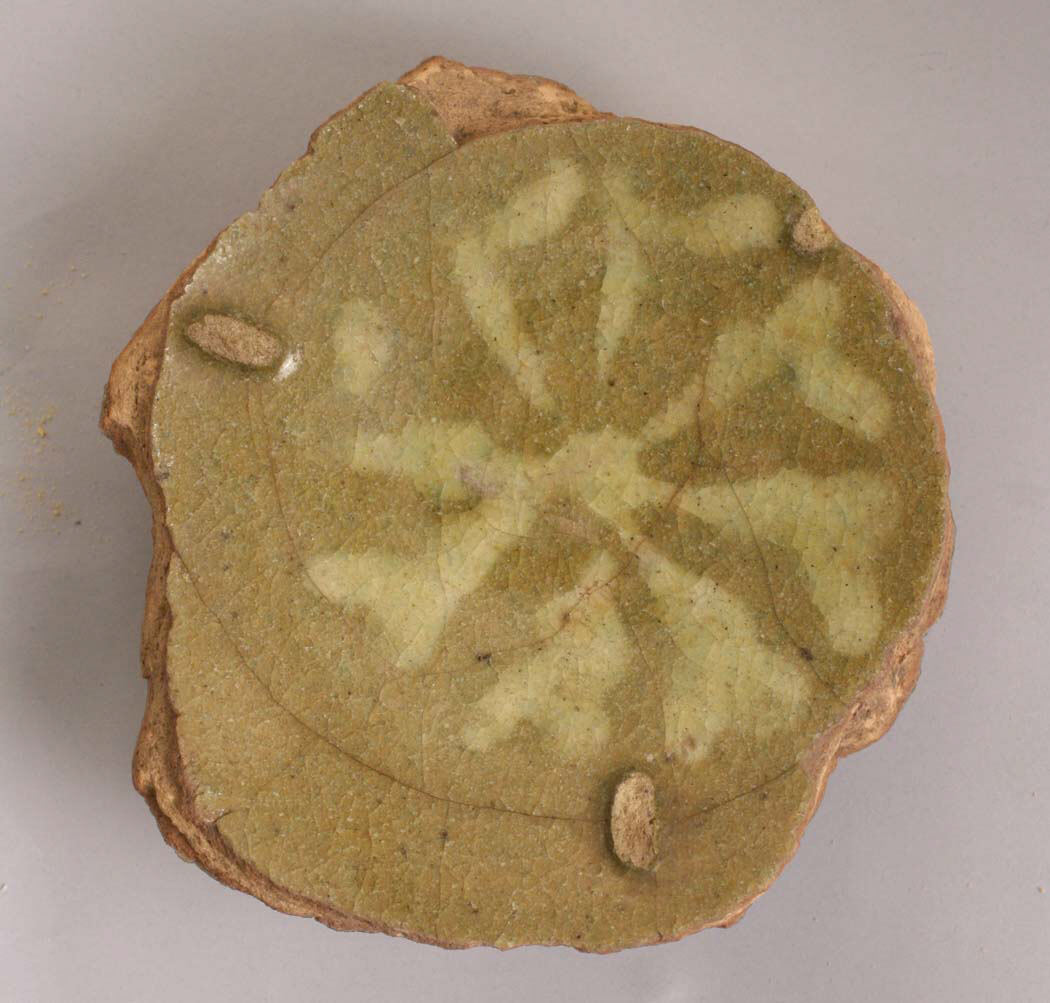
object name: ceramic fragment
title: Fragment of Dish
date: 1301-1500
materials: glaze, stonepaste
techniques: painting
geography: egypt